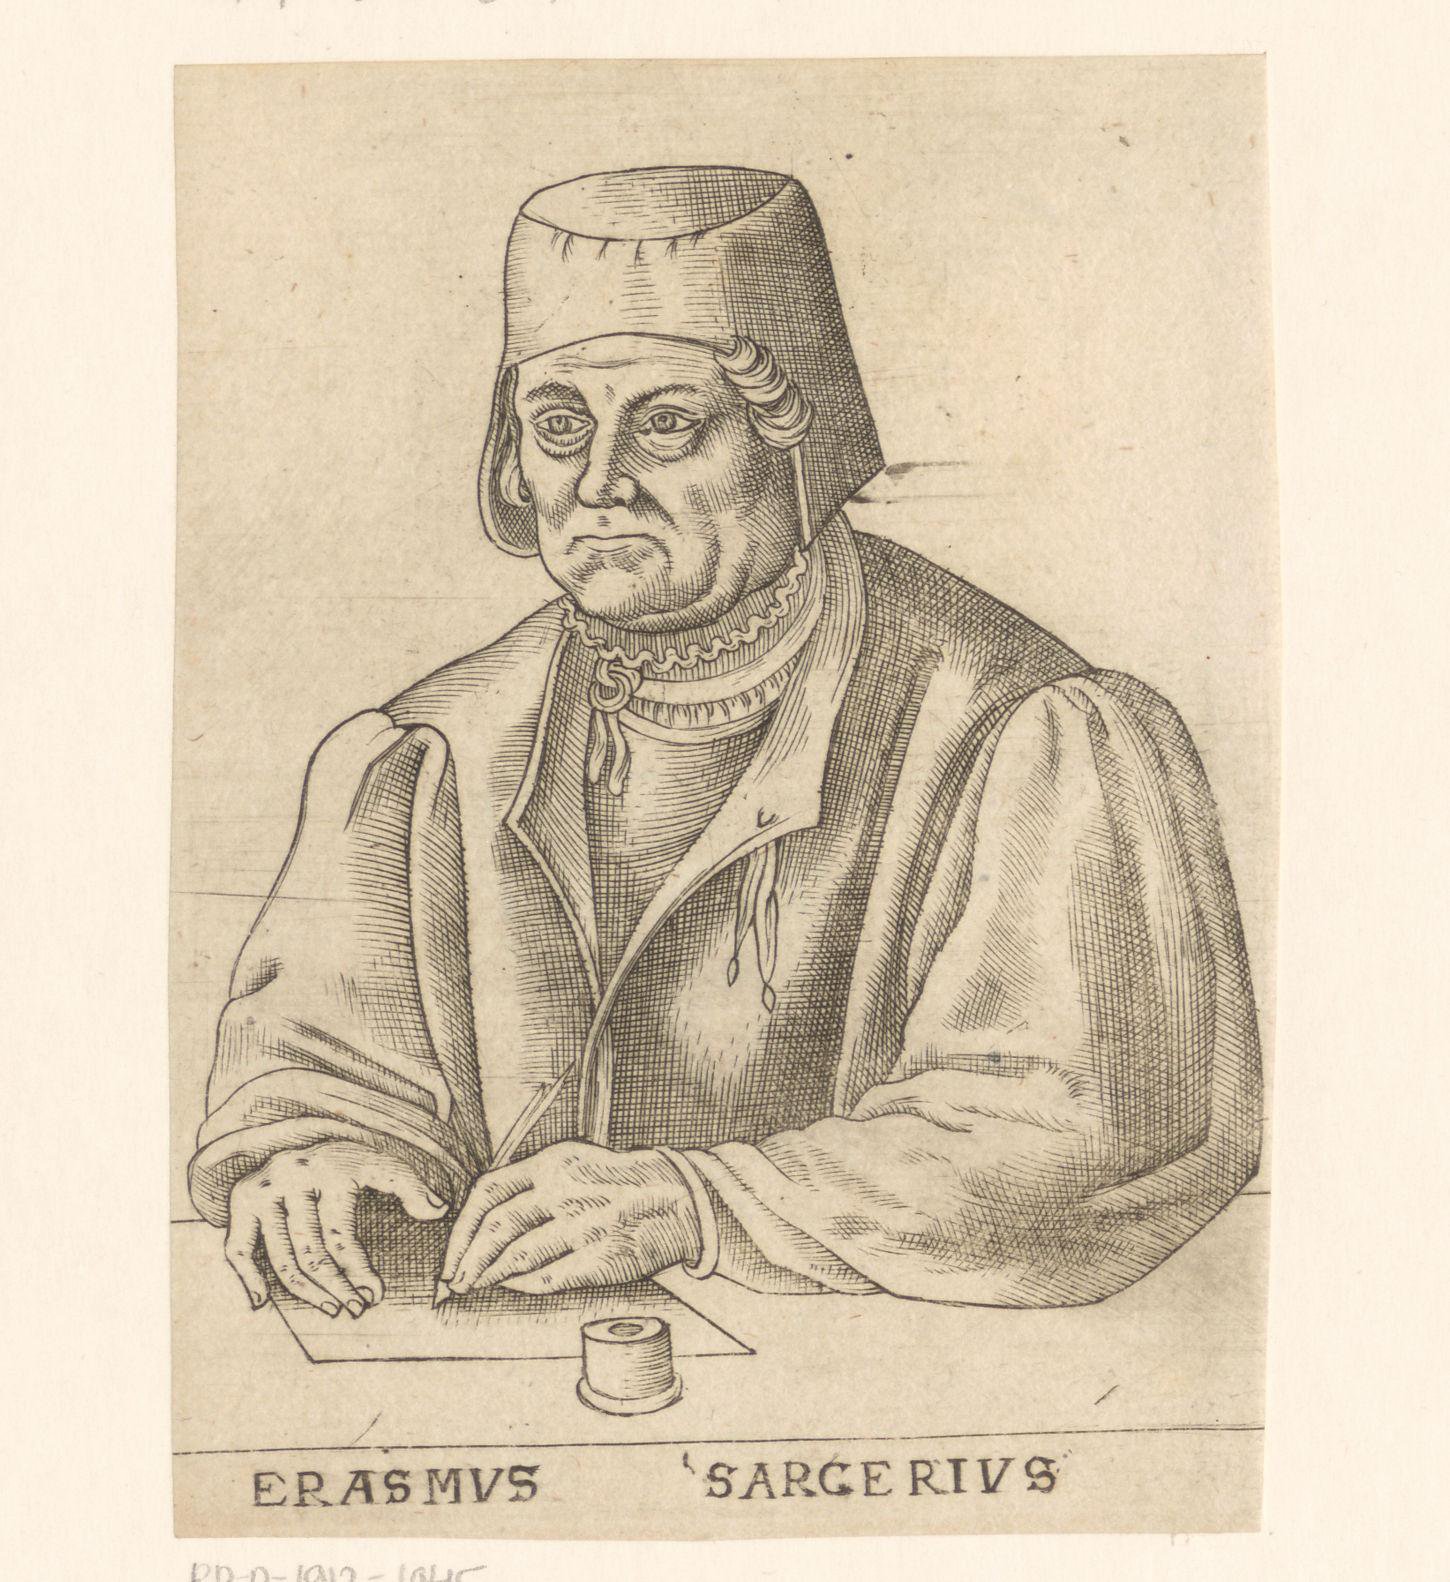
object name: print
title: Portret van Erasmus Sarcerius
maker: Anonymous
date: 1563-1642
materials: paper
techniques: engraving, etching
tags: theologian, historical persons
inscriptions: collector's mark: Lugt 2228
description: Deze prent (een impressie) hoort bij een serie portretten van sturende personen tijdens de reformatie.